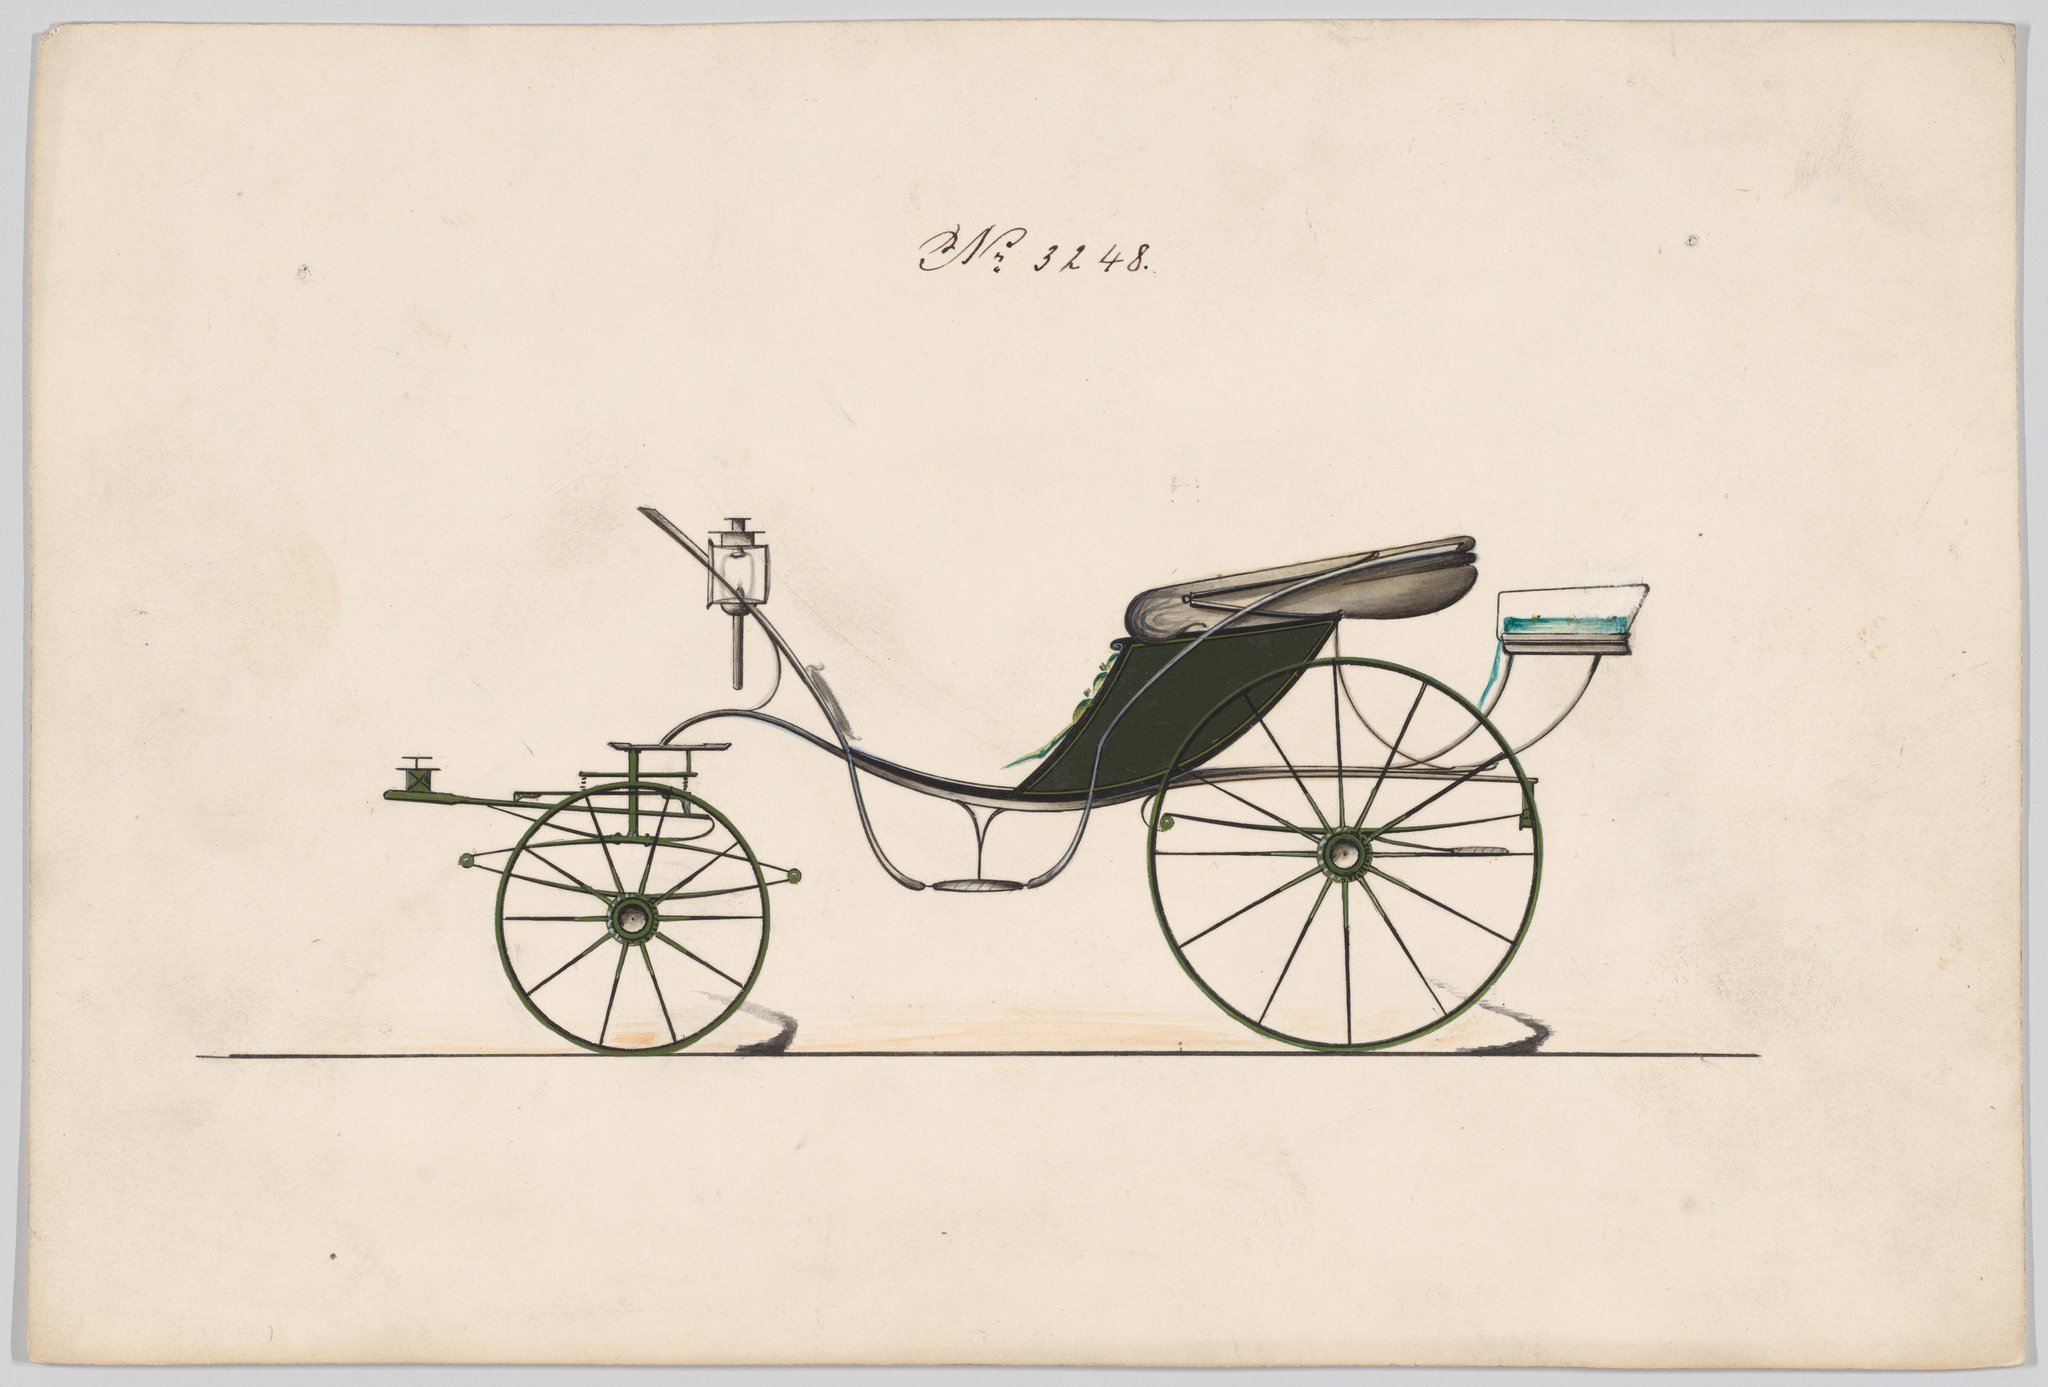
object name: drawing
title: Design for Pony Phaeton, no. 3248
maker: brewster & co.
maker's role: manufacturer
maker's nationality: american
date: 1876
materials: gouache, gum arabic, ink, watercolor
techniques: pen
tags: carriages